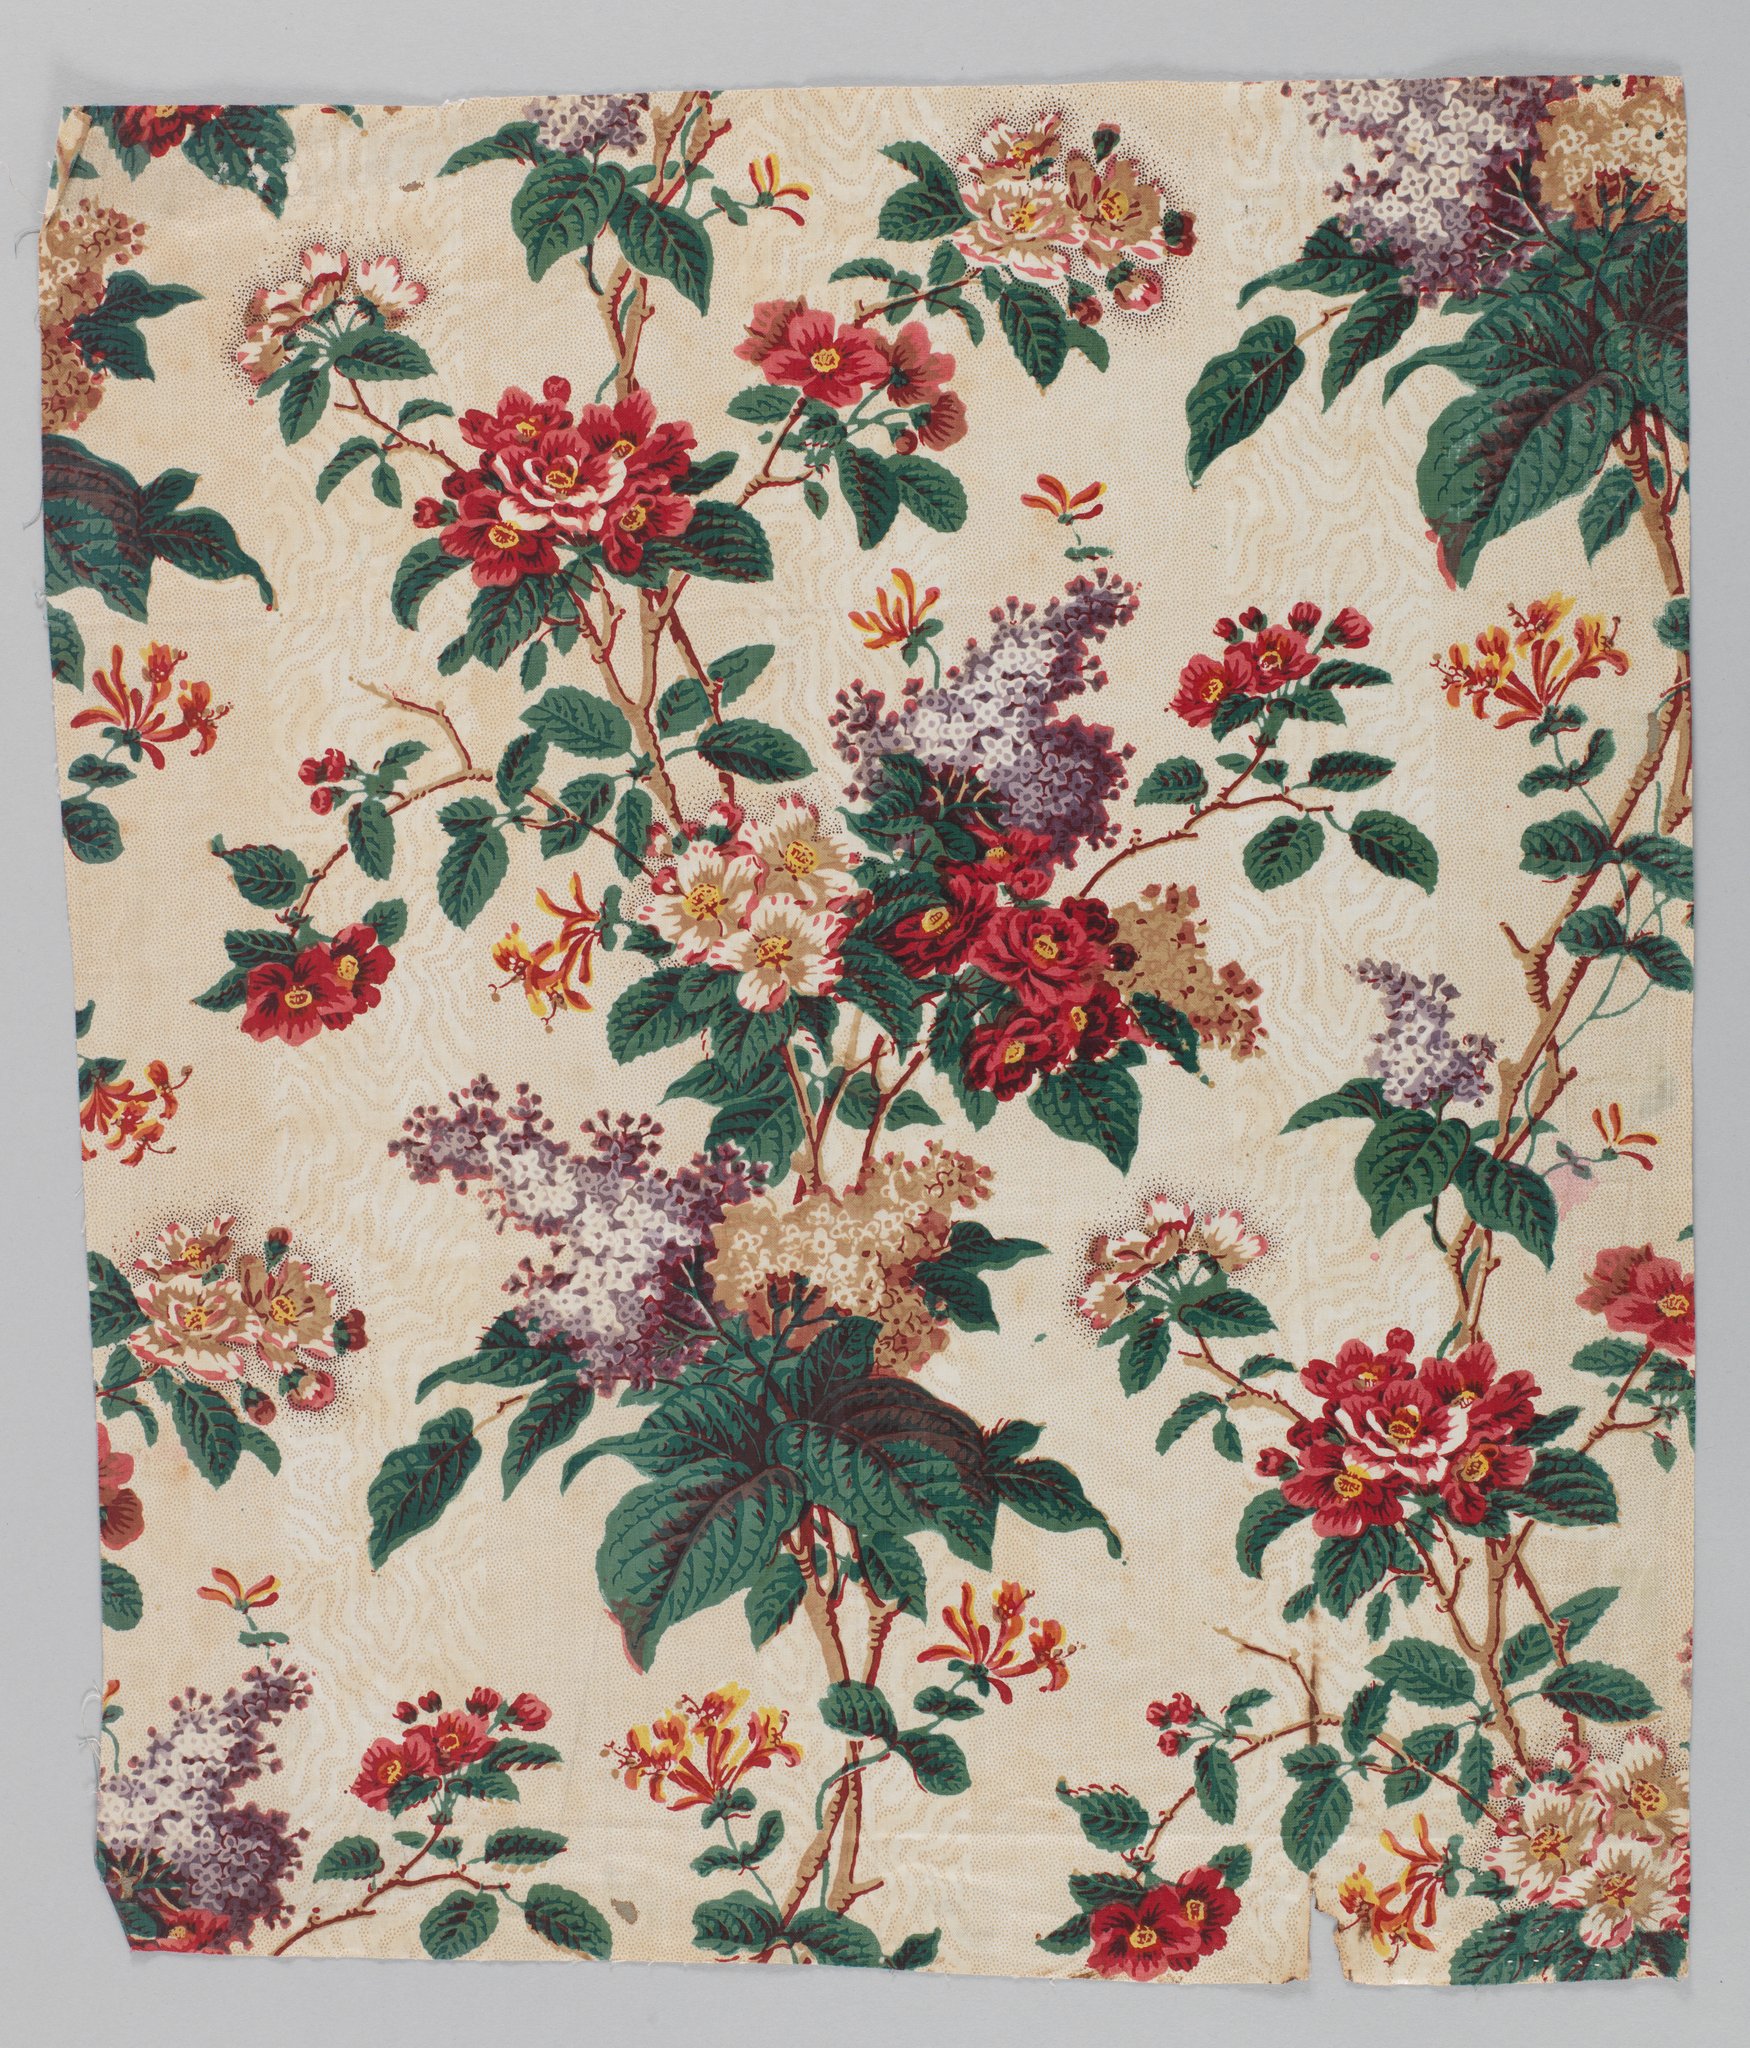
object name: piece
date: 1801-1900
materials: cotton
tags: flowers